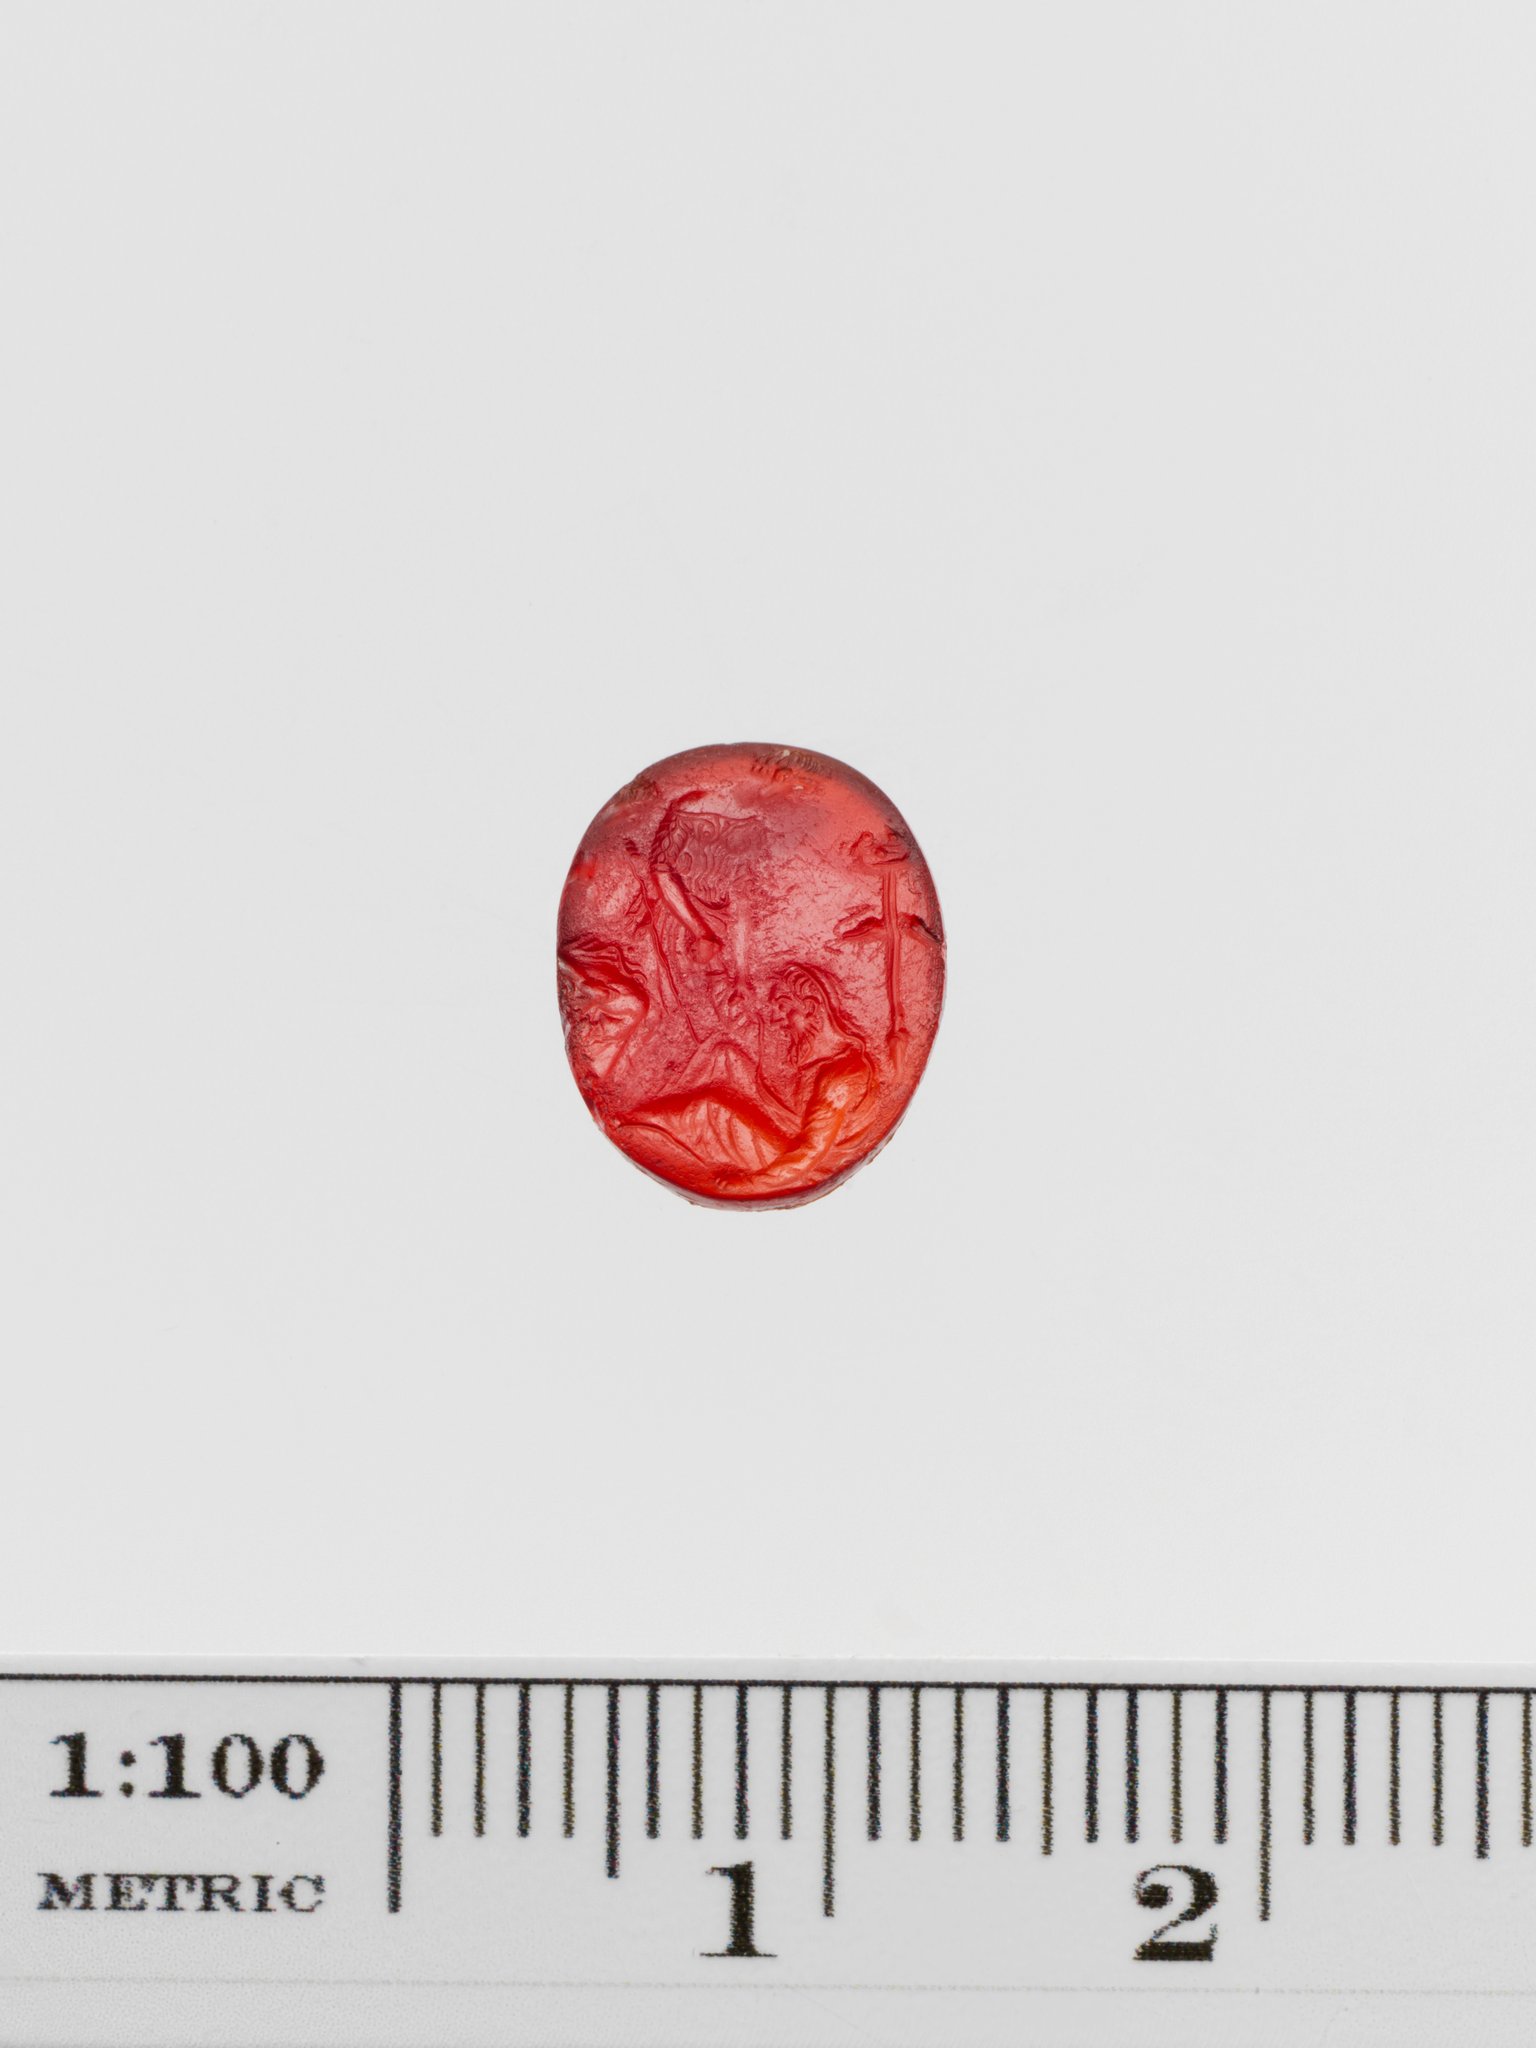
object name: intaglio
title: Carnelian ring stone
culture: roman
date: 100 BCE-300 CE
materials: gemstone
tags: men,women